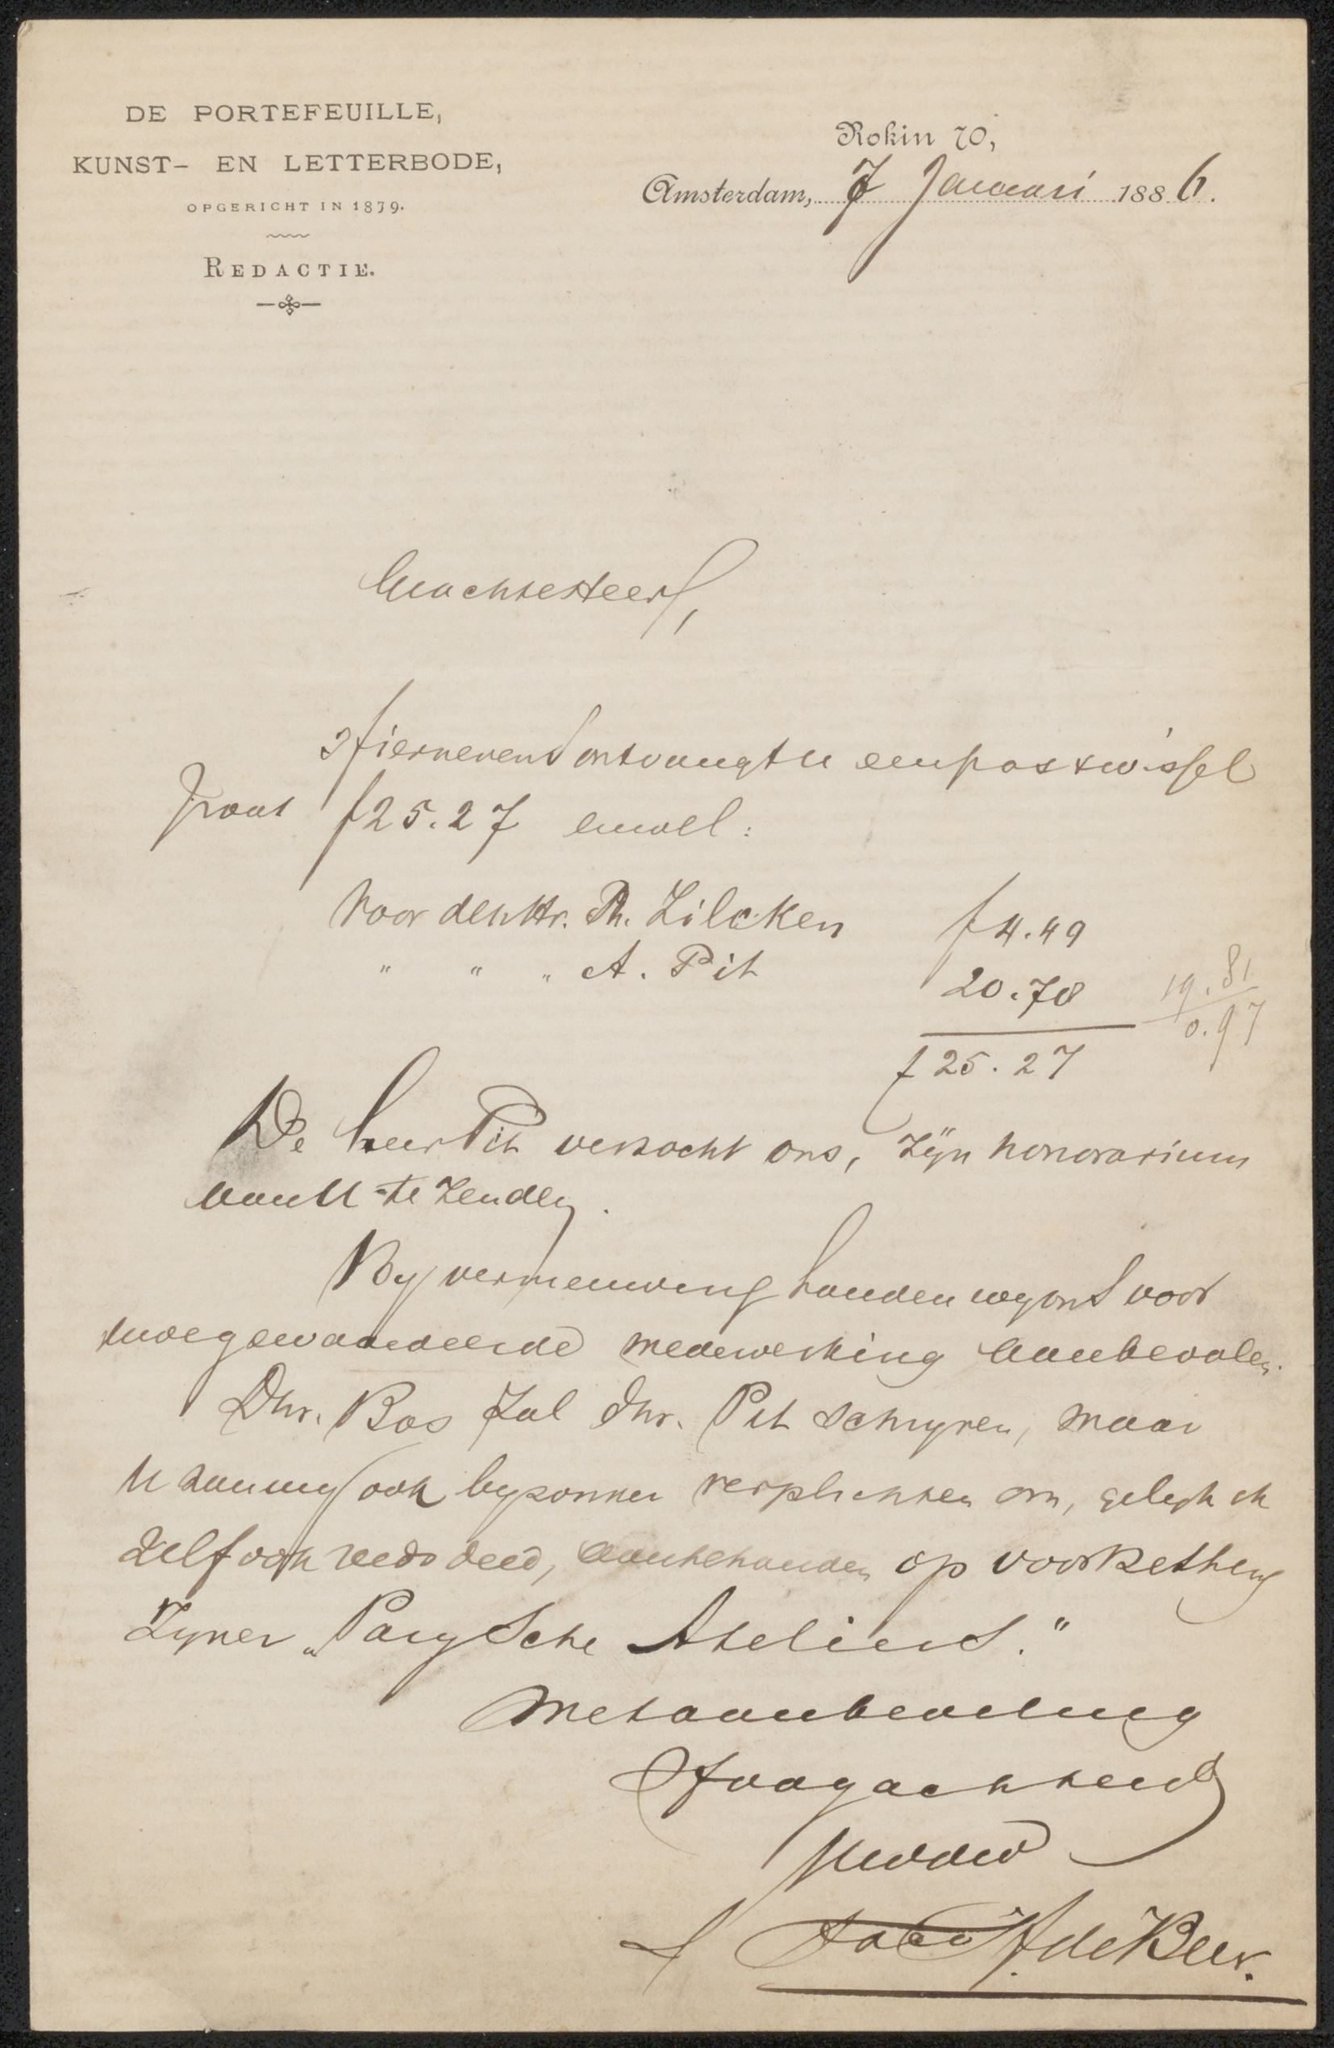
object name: letter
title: Brief aan onbekend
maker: taco h. de beer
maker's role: auteur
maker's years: 1838-1923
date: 1886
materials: ink, paper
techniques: pen, printing, writing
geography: amsterdam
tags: the hague, nijmegen, print maker, adriaan pit, painter, philip zilcken, money, printed matter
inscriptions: collector's mark: ‘RPK’